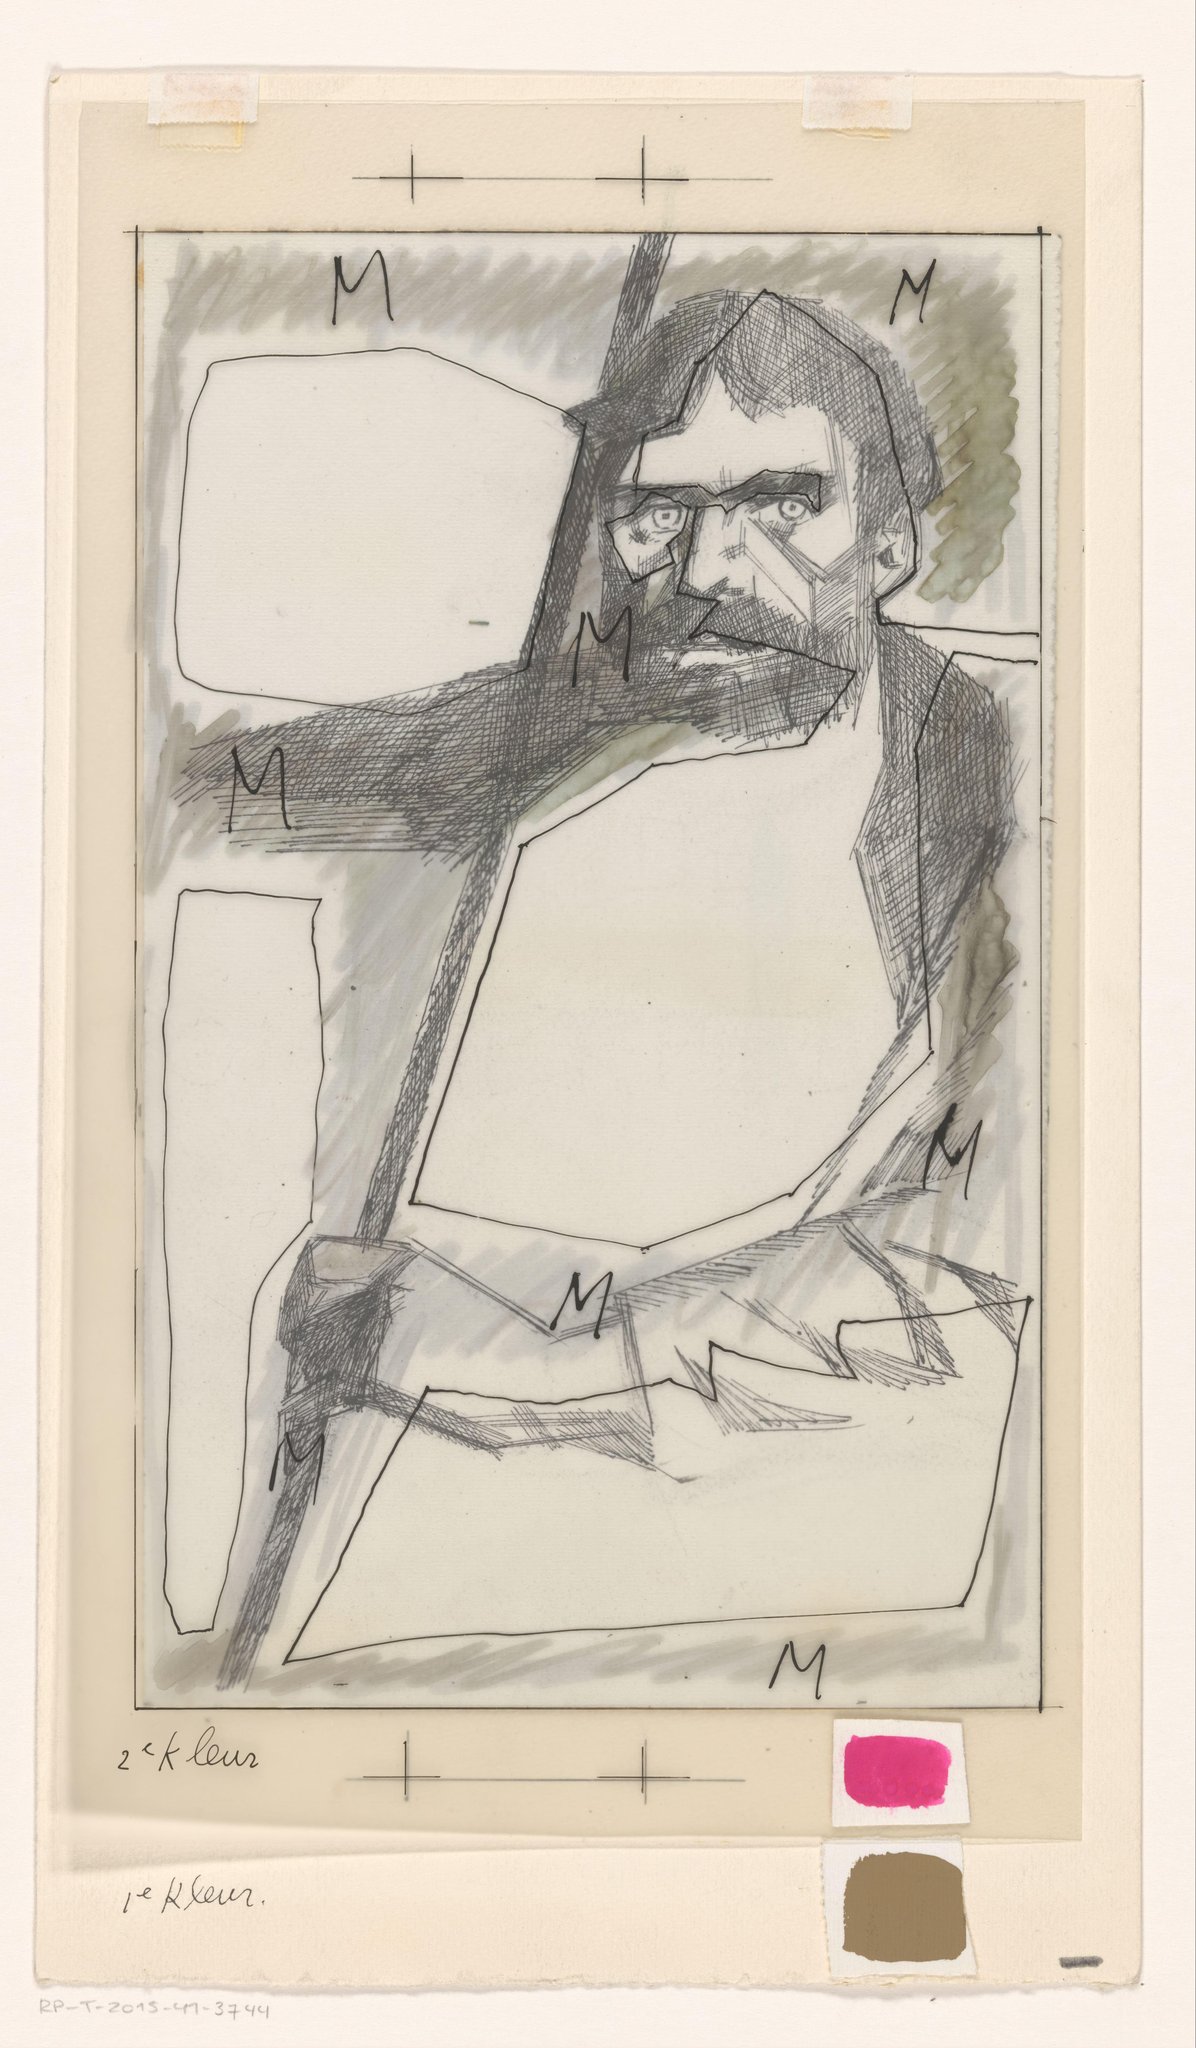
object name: drawing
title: Bandontwerp voor: N.S. Ljeskow, De onsterfelijke, 1965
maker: karel thole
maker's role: painter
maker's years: 1914-2000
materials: ink, paper, pencil, pressure sensitive tape, watercolor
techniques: brush, pen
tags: walking-stick, staff, beard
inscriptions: : ‘2e kleur/ 1e kleur’, collector's mark: Lugt 2228a, annotation: ‘DE ONSTERFELIJKE’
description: Man met baard die een staf in zijn linkerhand houdt.